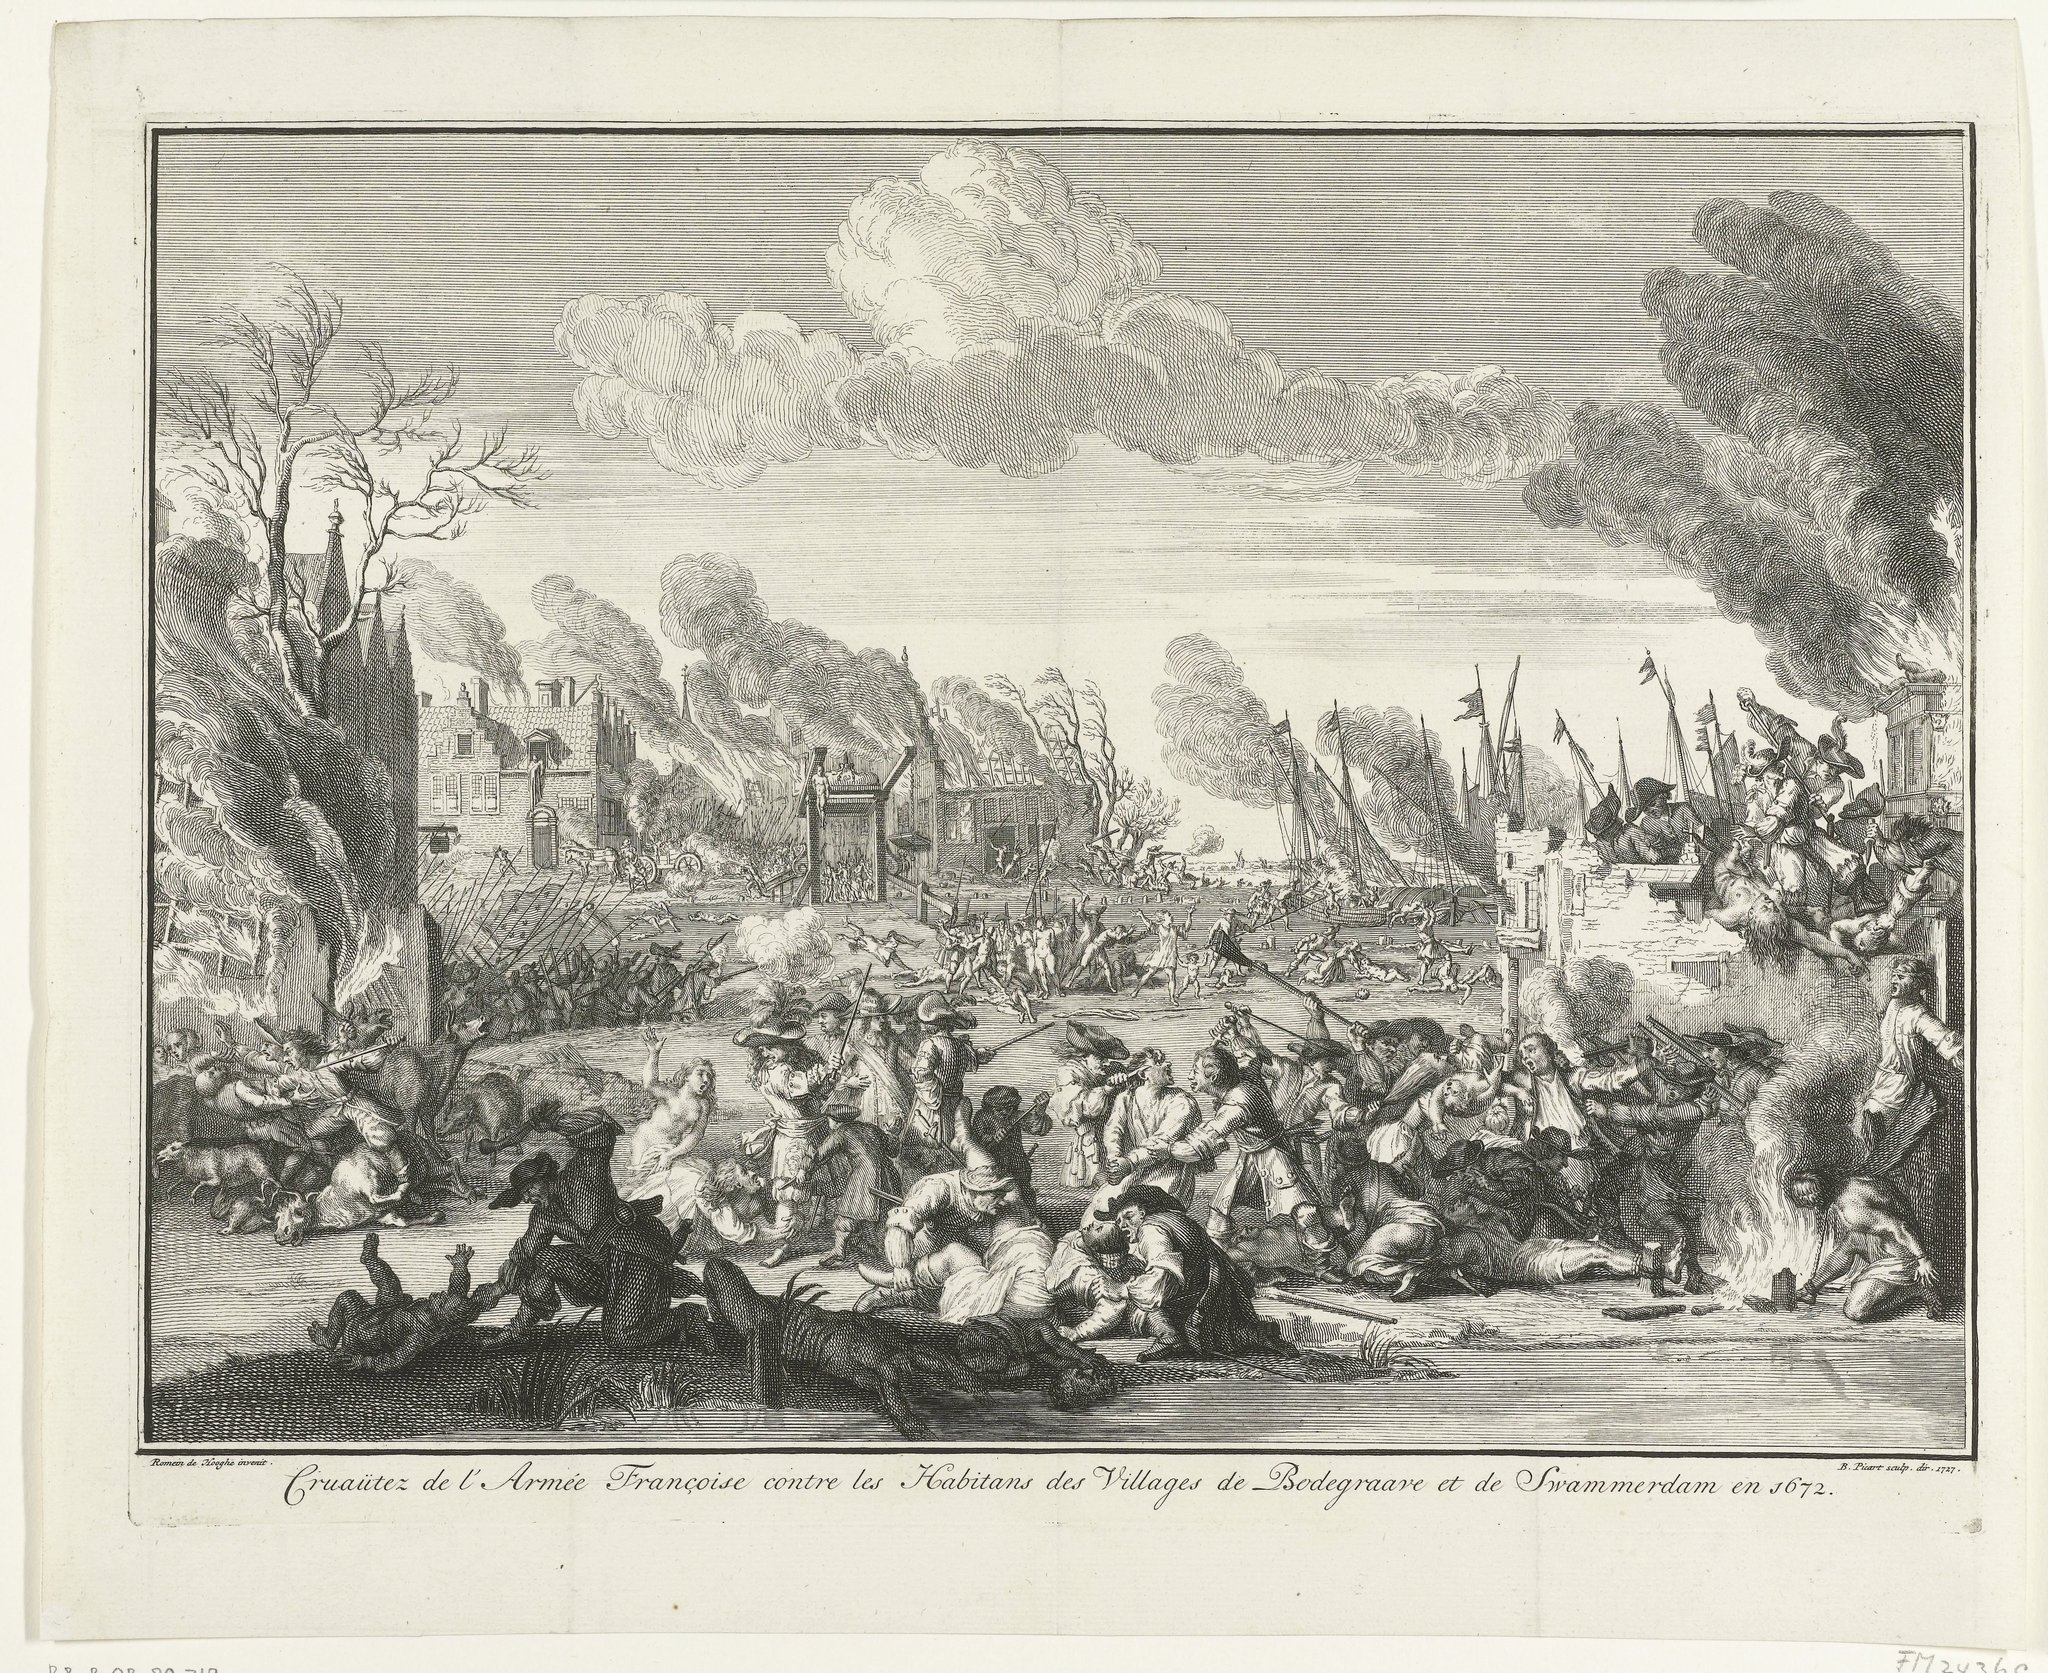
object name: print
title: Cruaütez de l'Armée Françoise contre les Habitans des Villages de Bodegraave et de Swammerdam en 1672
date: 1727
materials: paper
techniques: engraving, etching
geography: northern netherlands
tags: rape, violation, plundering ~ soldiers, violent death, being killed; being mishandled and maltreated; seeking death, massacre ~ war, bodegraven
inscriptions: signature and date: ‘B. Picart sculp. dir. 1727’, inscription: ‘Cruaütez de l'Armée Françoise contre les Habitans des Villages de Bodegraave et de Swammerdam en 1672’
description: De plaat eerst uitgegeven als illustratie in: J. le Clerc, Histoire des Provinces-Unies des Pays-Bas, Amsterdam 1723-1728, 4 delen. Hierna ook gebruikt als illustratie de Nederlandse uitgave: J. le Clerc, Geschiedenissen der Vereenigde Nederlanden, sedert den aanvang van die Republyk tot op den Vrede van Utrecht in 't jaar 1713 en het Tractaat van Barriere in 't jaar 1715 gesloten, Z. Chatelain, Amsterdam 1730, 3 delen. Kopie naar de prent van Romeyn de Hooghe (FMH 2435).